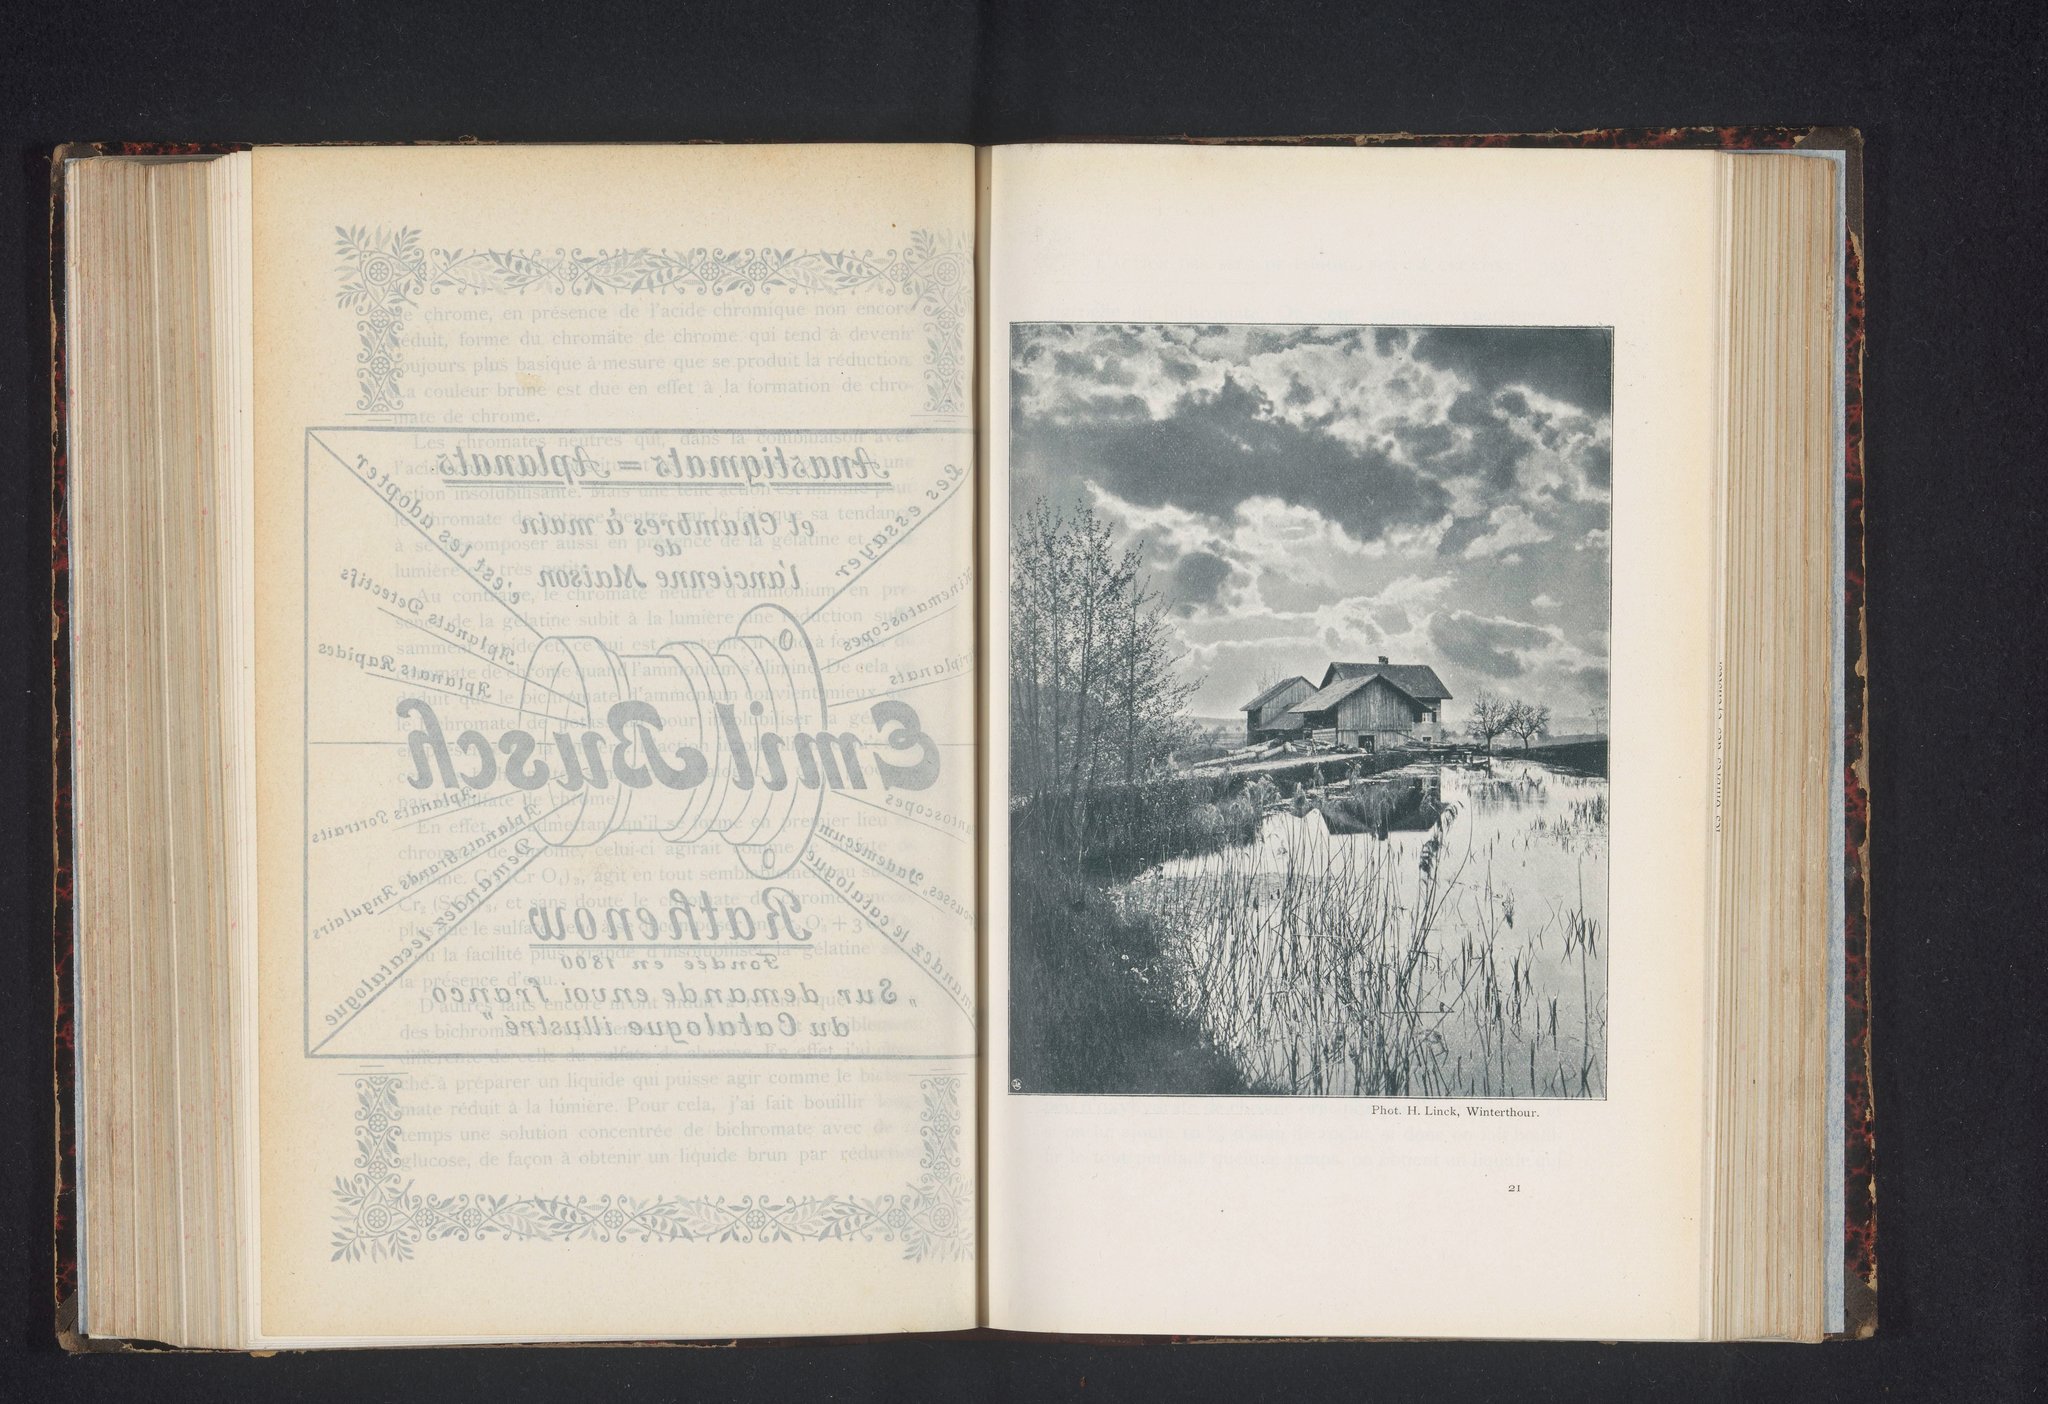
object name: photomechanical print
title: Landschap met een boerderij aan een vijver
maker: hermann linck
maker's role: fotograaf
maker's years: 1866-1938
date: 1897-1902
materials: paper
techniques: autotype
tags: landscapes, pond, pool, farm or solitary house in landscape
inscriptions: monogram: ‘C. Cie’